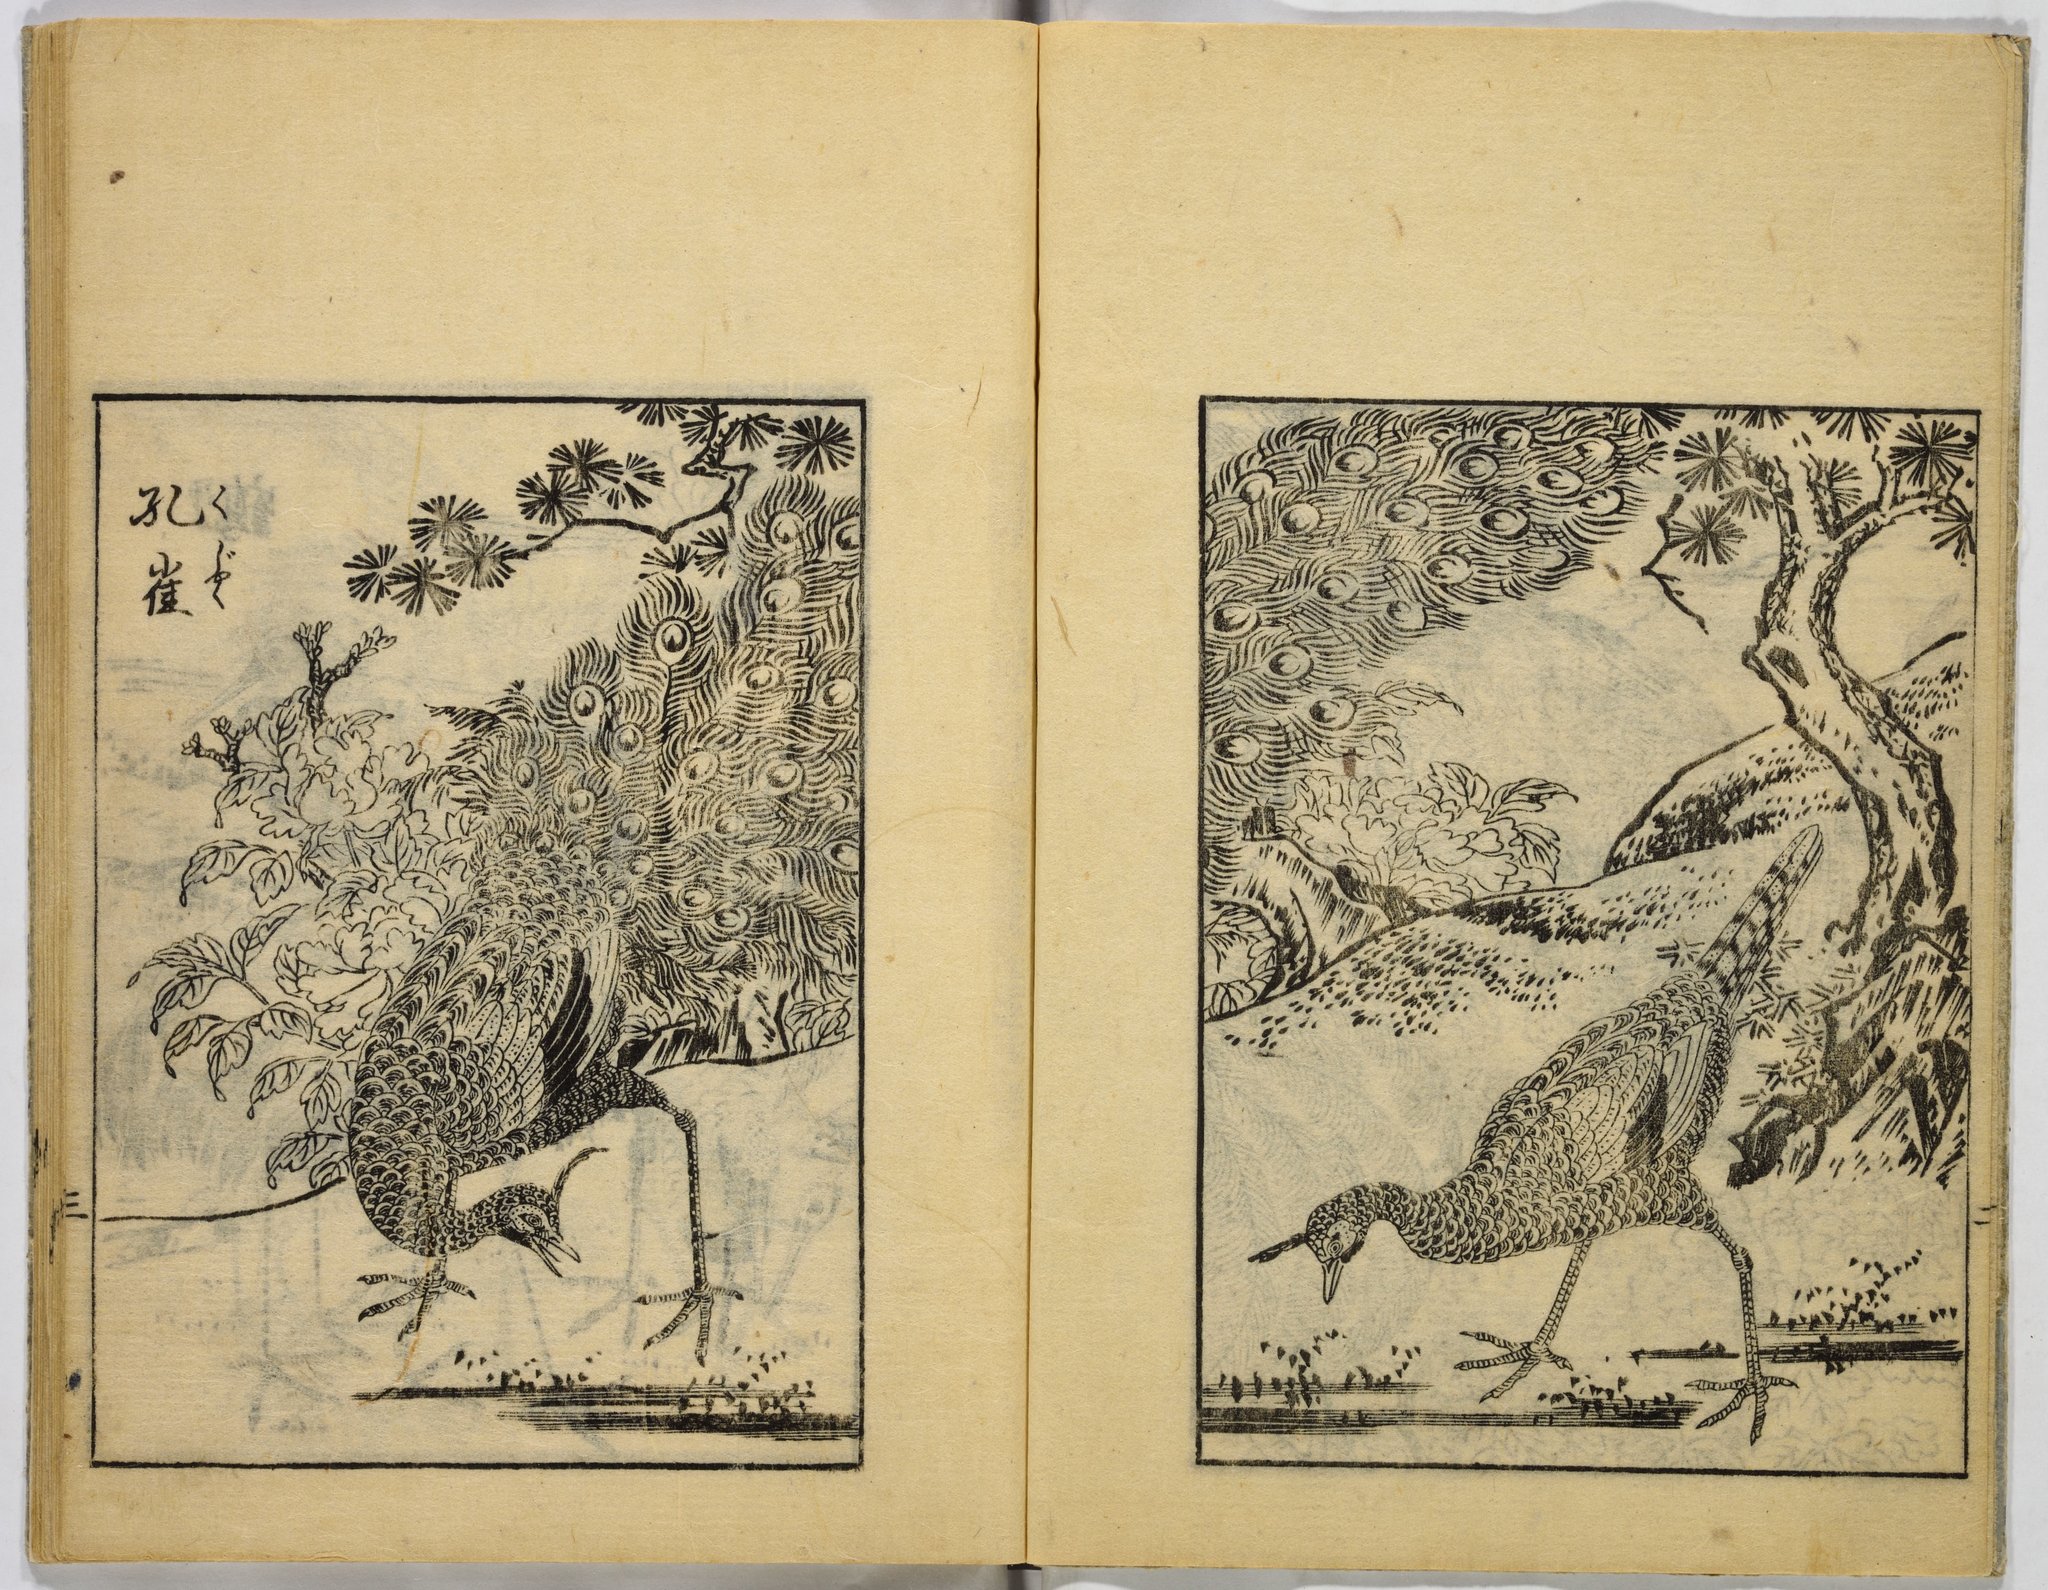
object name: illustrated book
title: Model Painting Book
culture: japanese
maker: unidentified artist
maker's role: artist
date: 1615-1868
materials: ink, paper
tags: peacocks